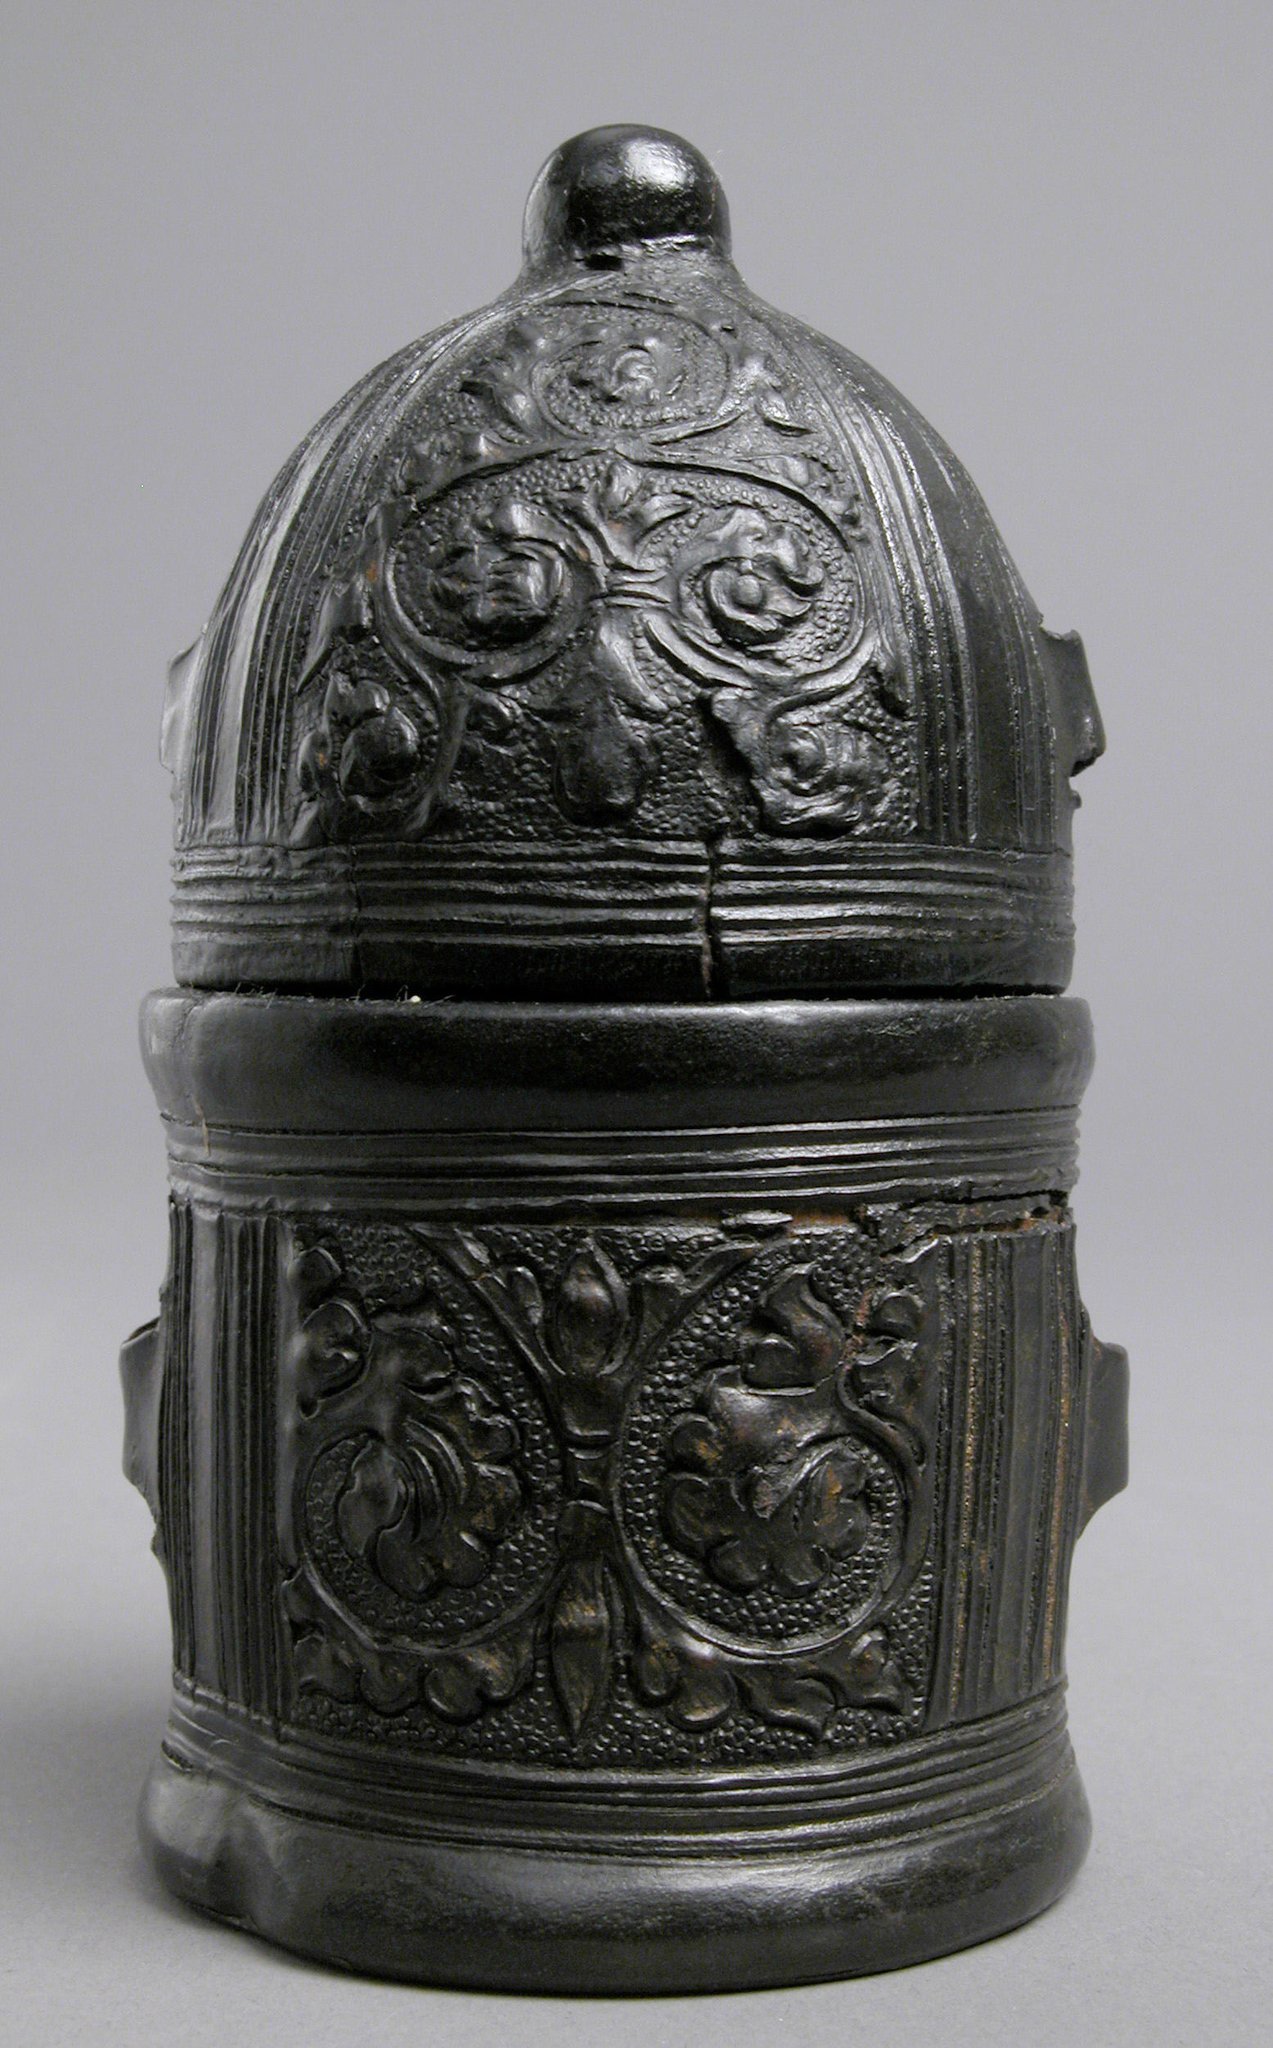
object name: box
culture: italian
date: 1401-1500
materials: leather, textile, wood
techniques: gilding